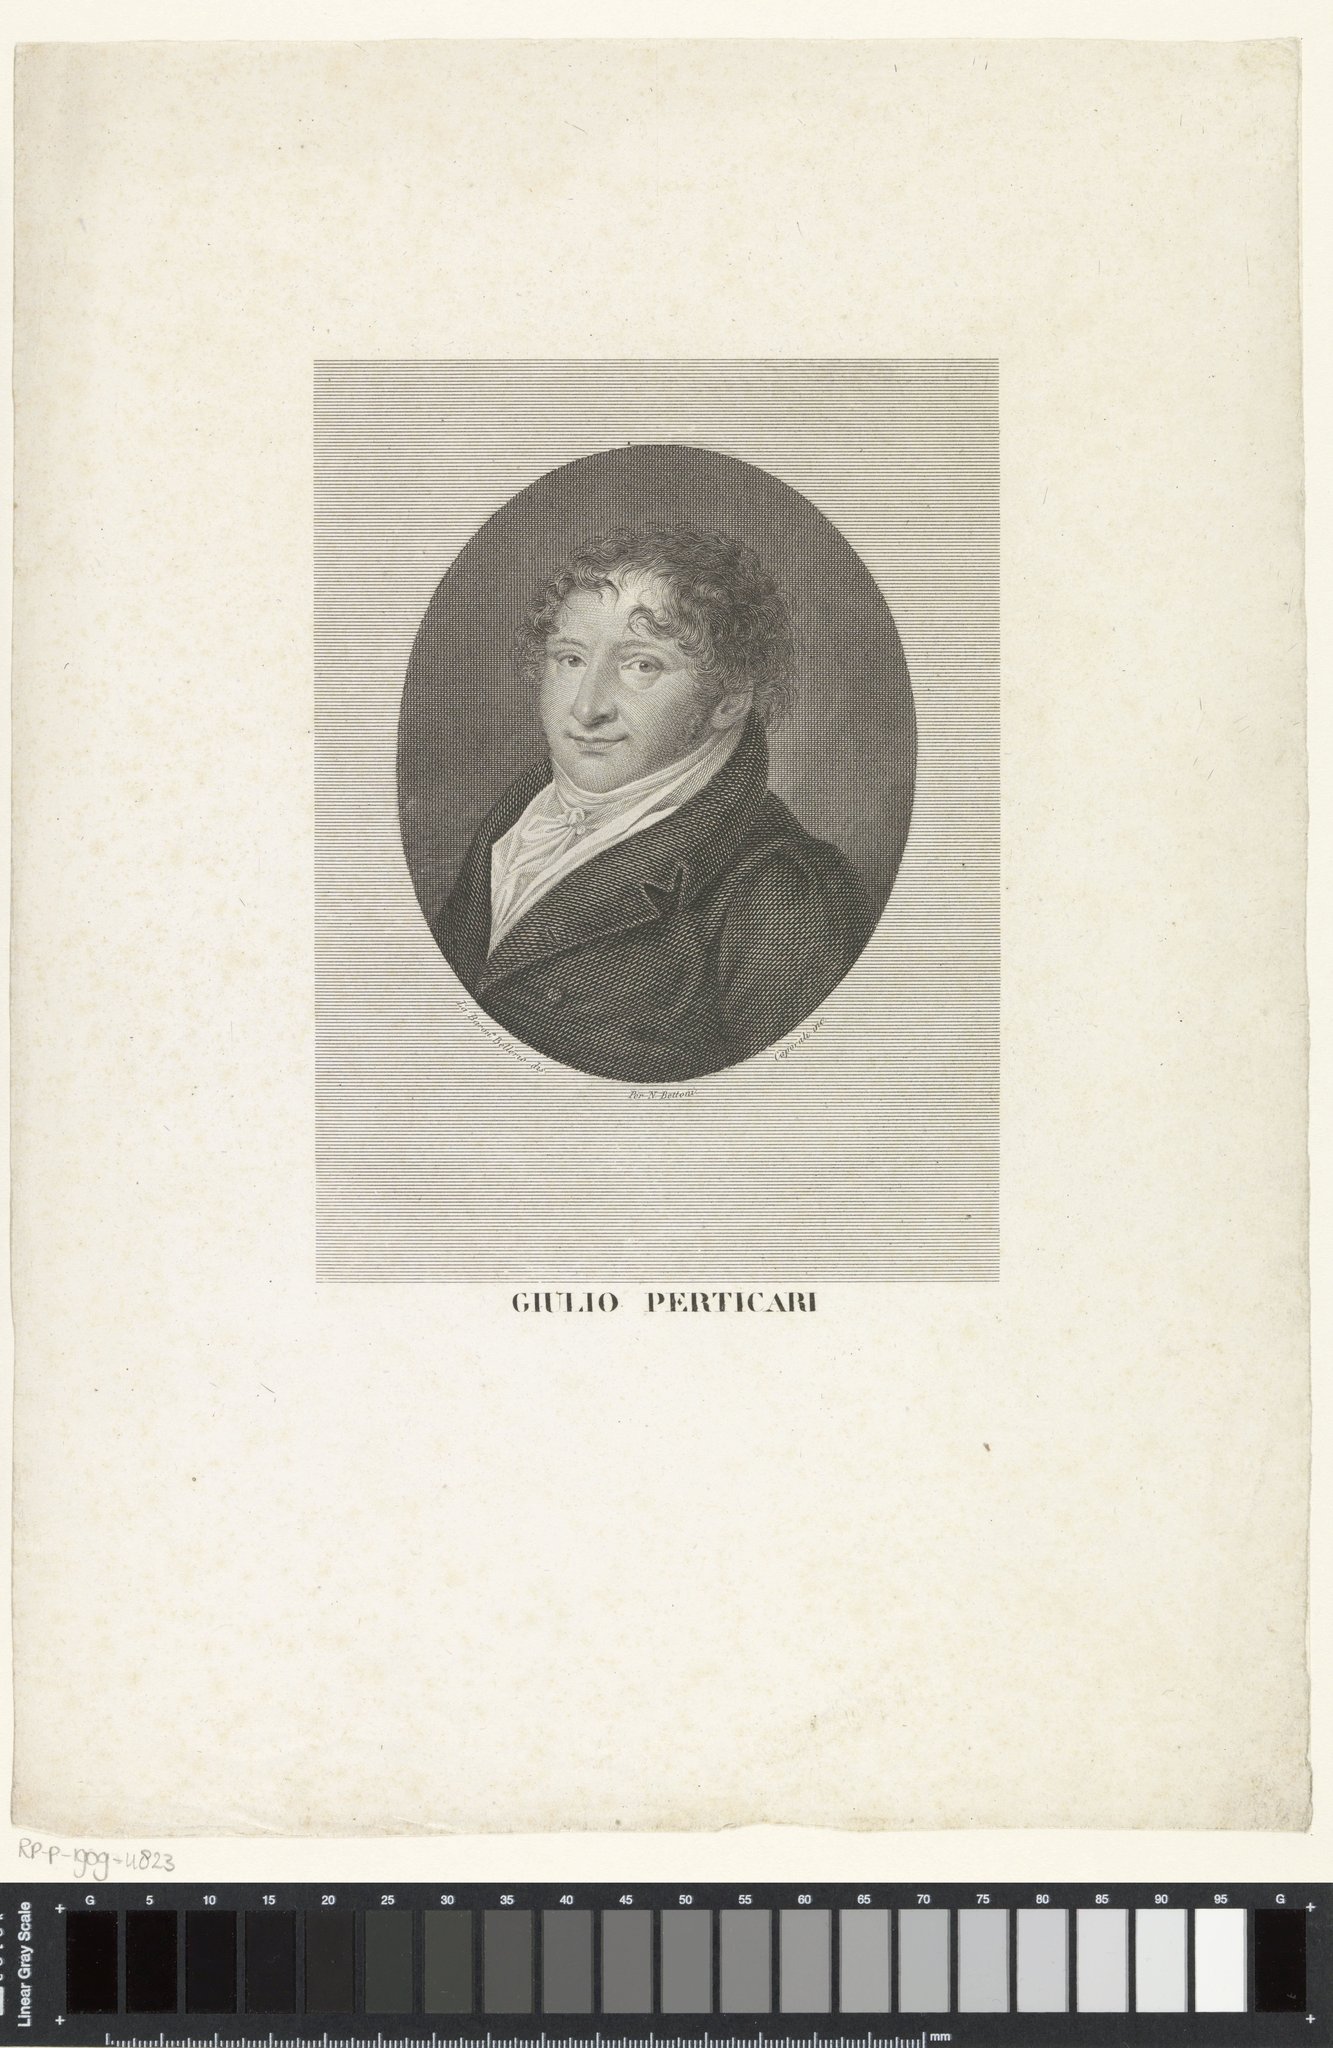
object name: print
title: Portret van de schrijver en dichter Giulio Perticari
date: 1804-1848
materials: paper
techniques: engraving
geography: italy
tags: historical persons, portrait of a writer, writer, poet, author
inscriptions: collector's mark: Lugt 2228